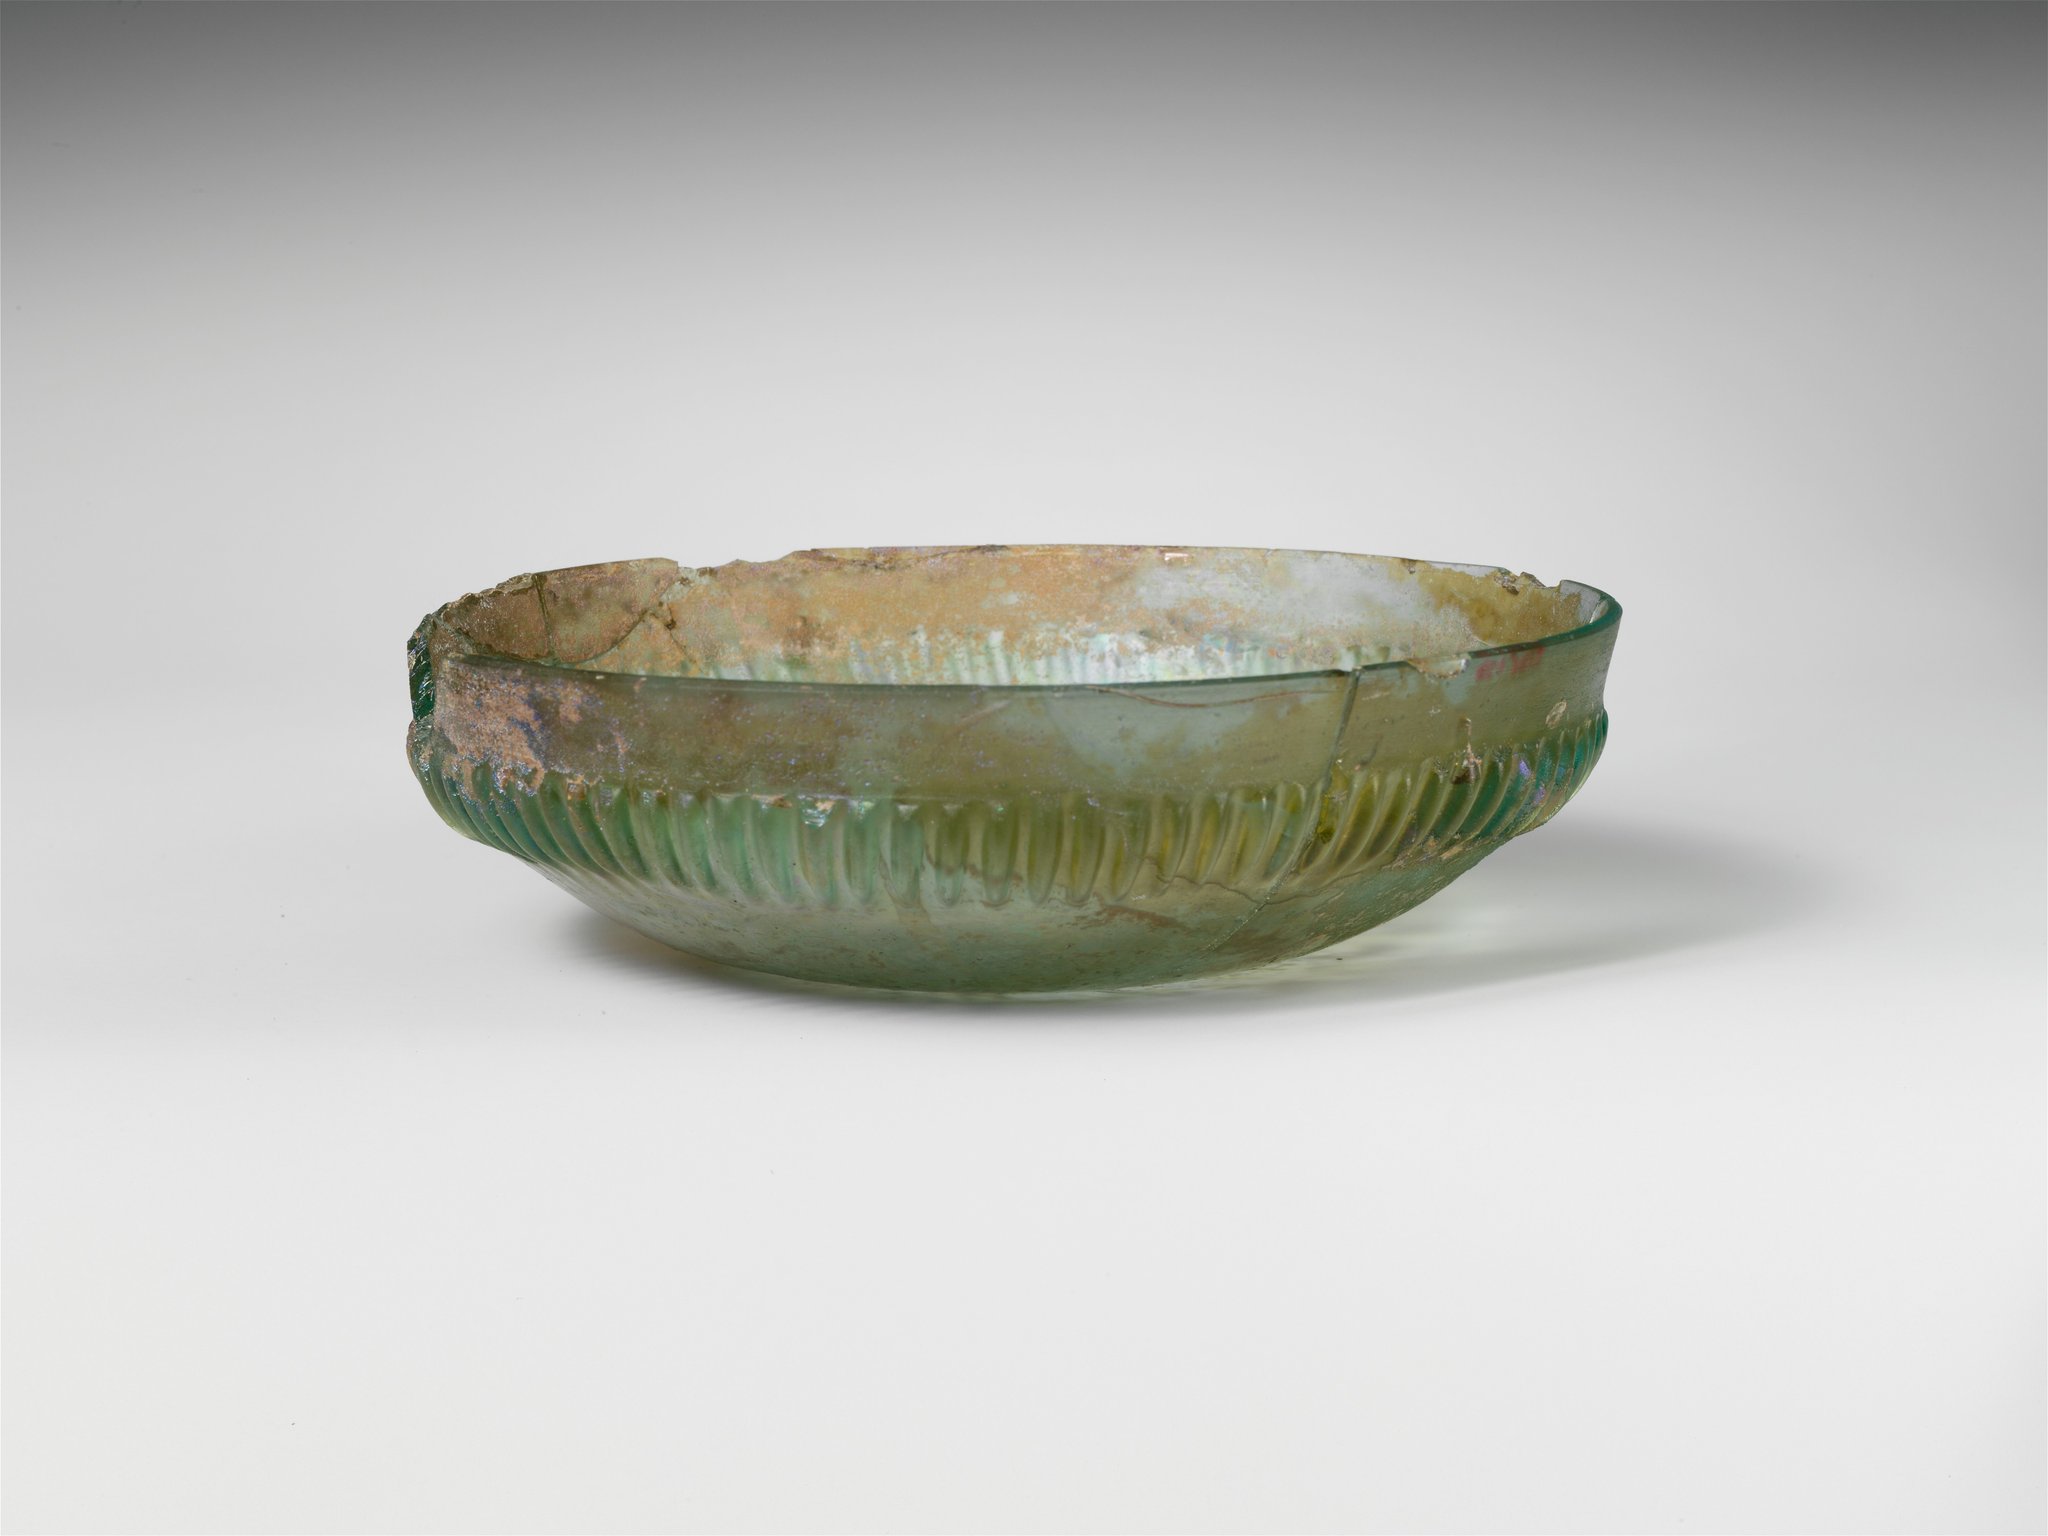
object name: bowl, ribbed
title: Ribbed glass bowl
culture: roman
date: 34 BCE-66 CE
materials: glass